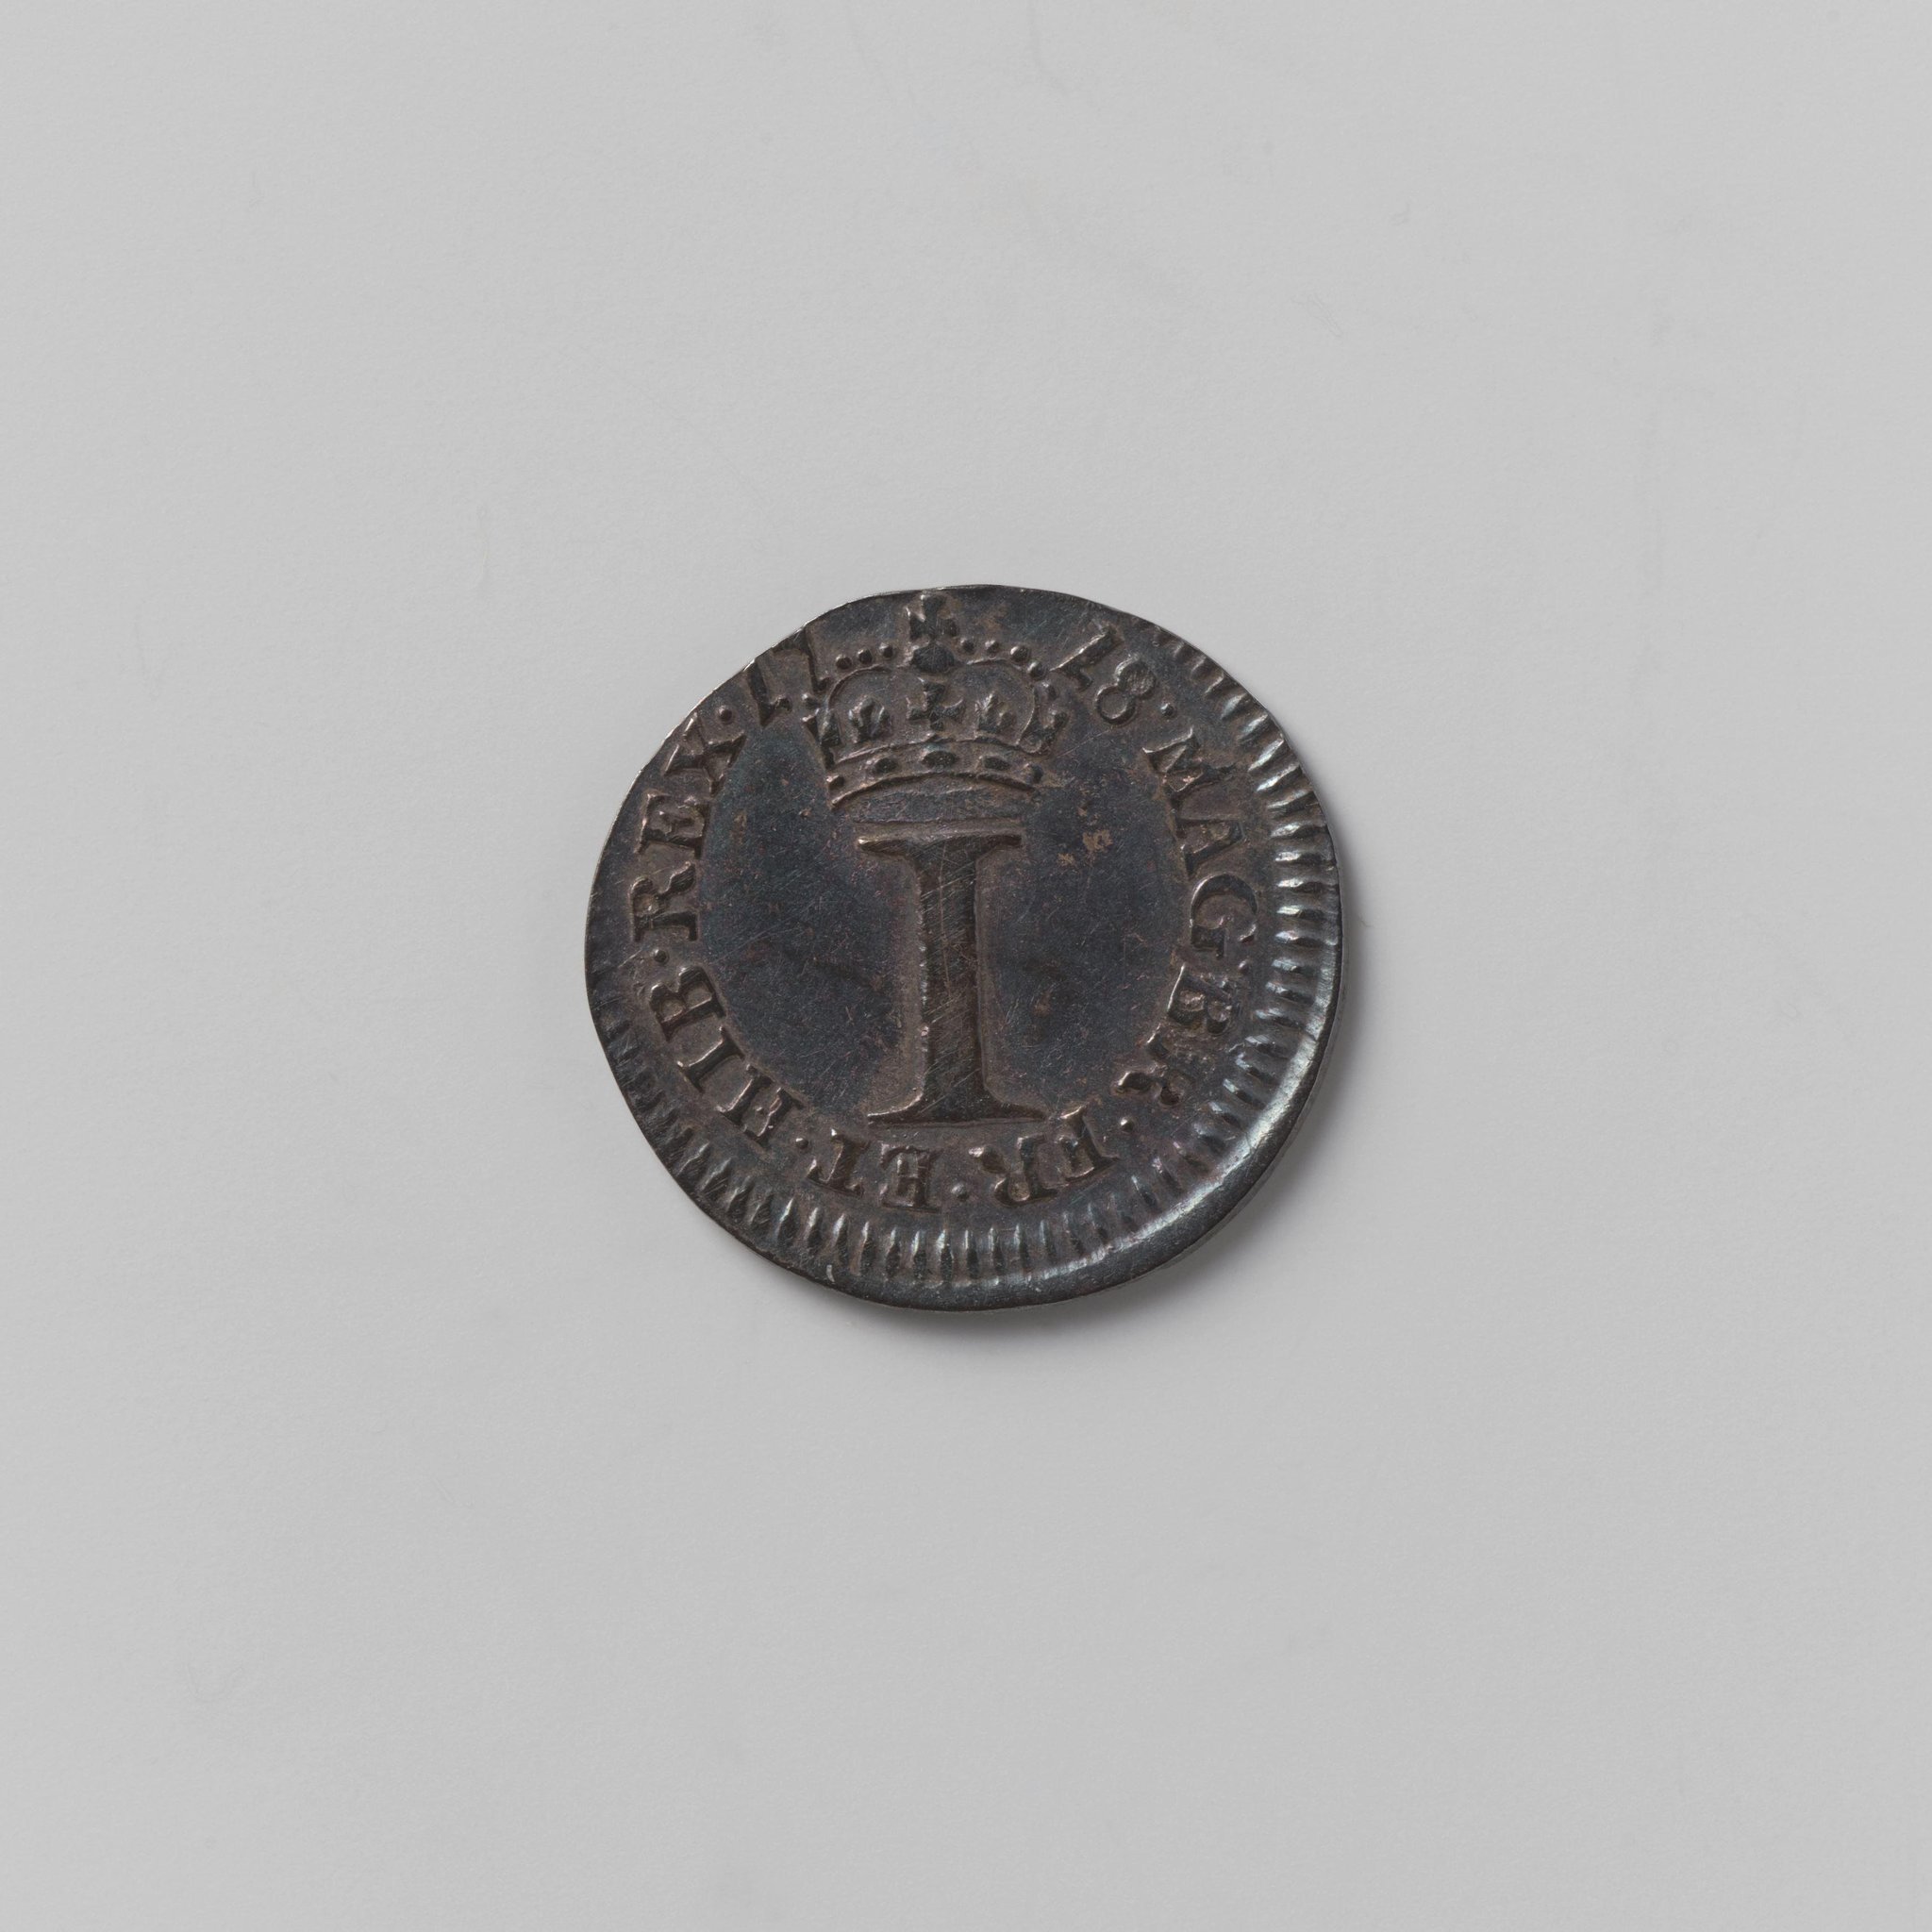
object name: coin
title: Engeland, George I, penny, 1718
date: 1708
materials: silver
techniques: striking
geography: london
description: Zilveren munt. Voorzijde: gelauwerd borstbeeld van de koning naar rechts. Keerzijde: gekroond cijfer een. Jaartal bovenaan rondom kroon.